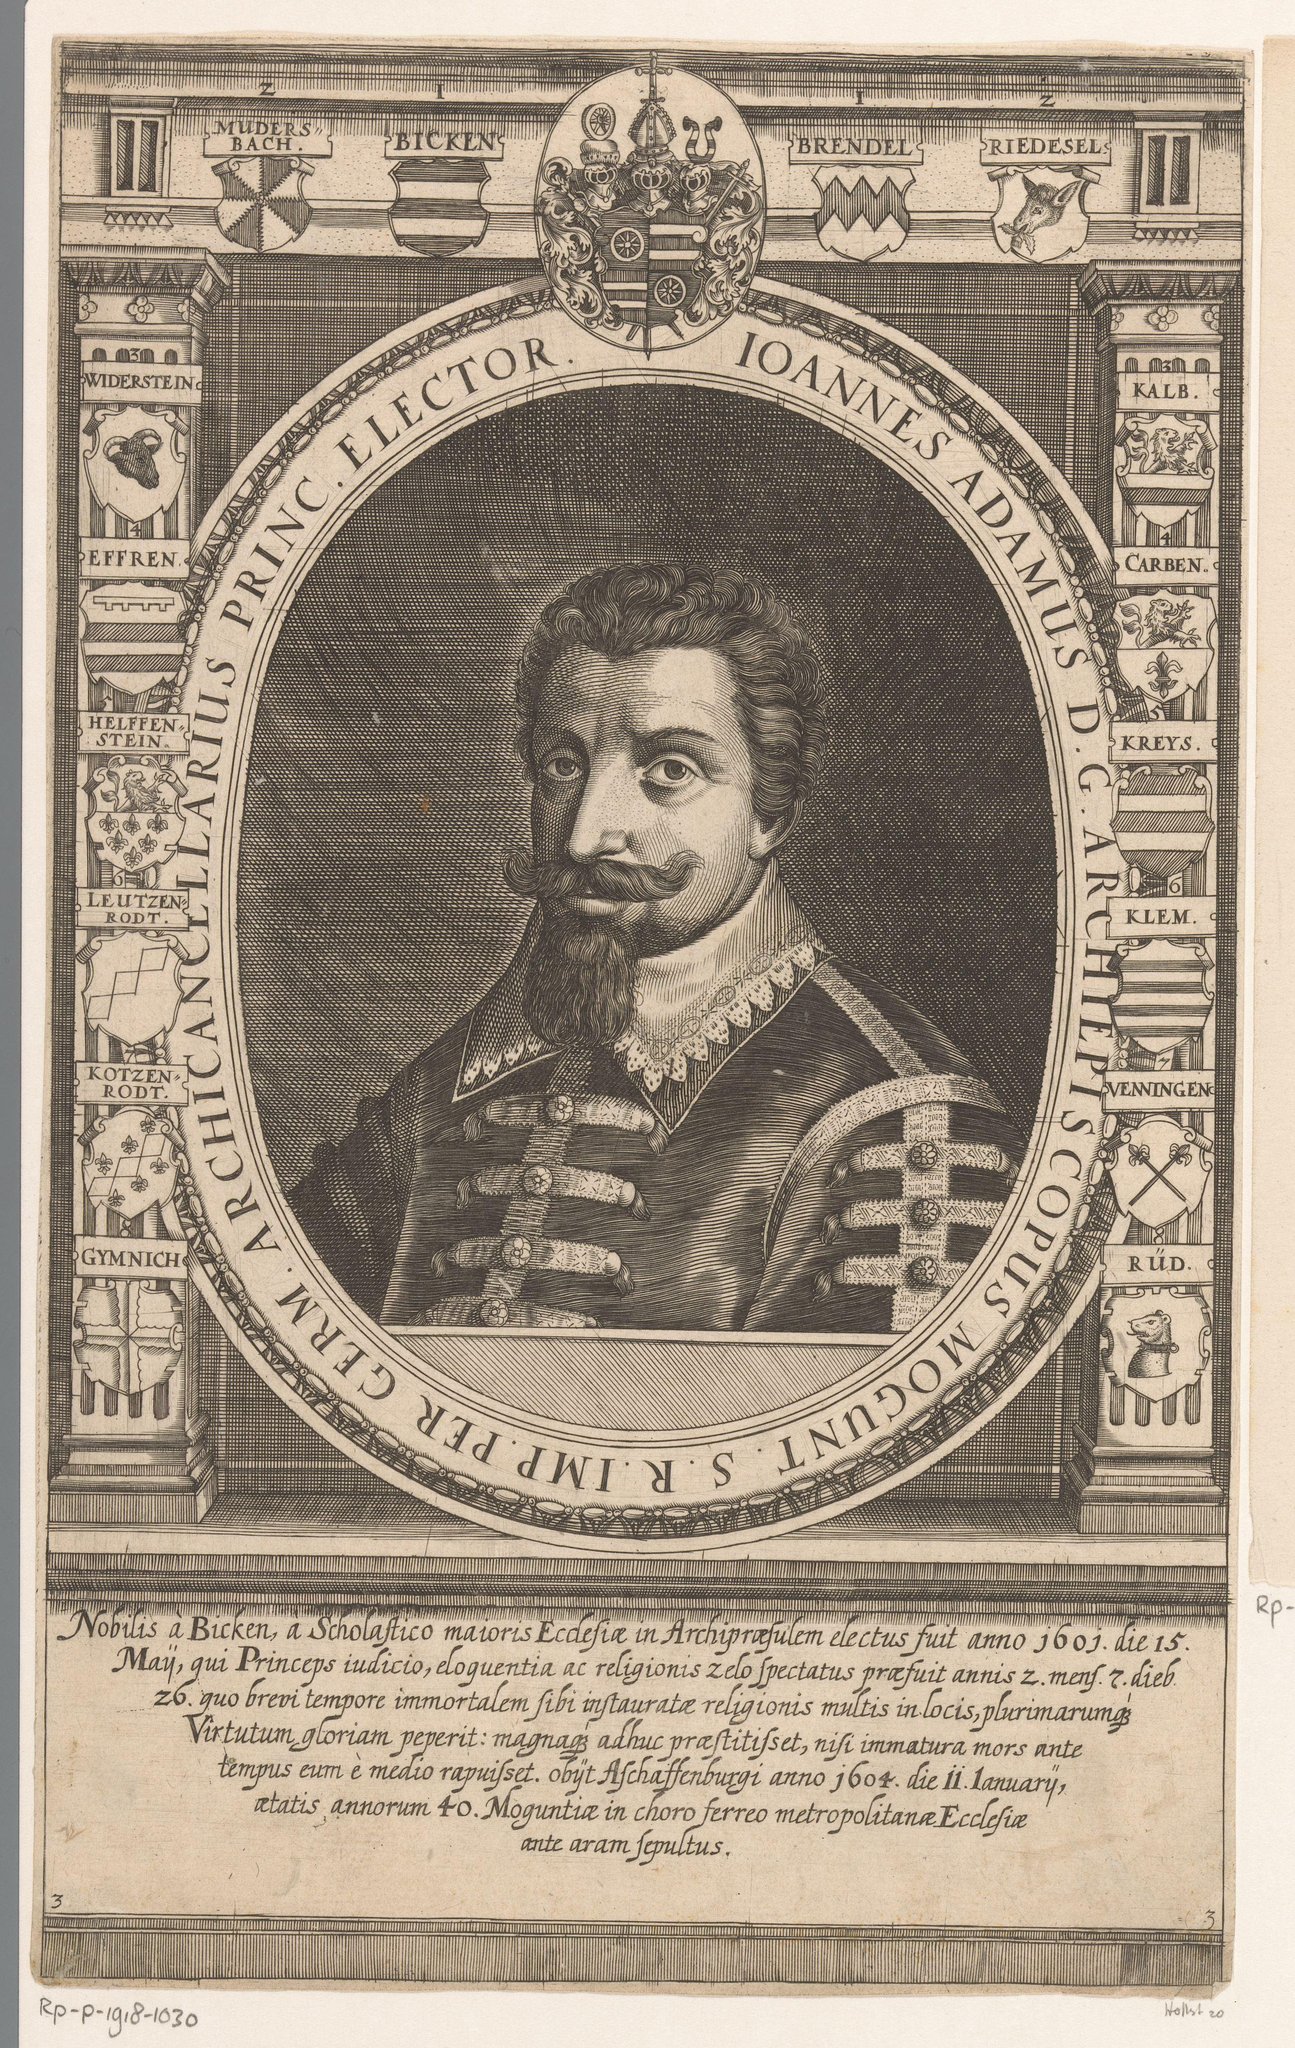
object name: print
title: Portret van Johann Adam von Bicken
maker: sebastian furck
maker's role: print maker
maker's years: 1600-1655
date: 1610-1655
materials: paper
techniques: engraving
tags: archbishop, bishop, etc. (roman catholic), historical persons, armorial bearing, heraldry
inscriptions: collector's mark: Lugt 2233